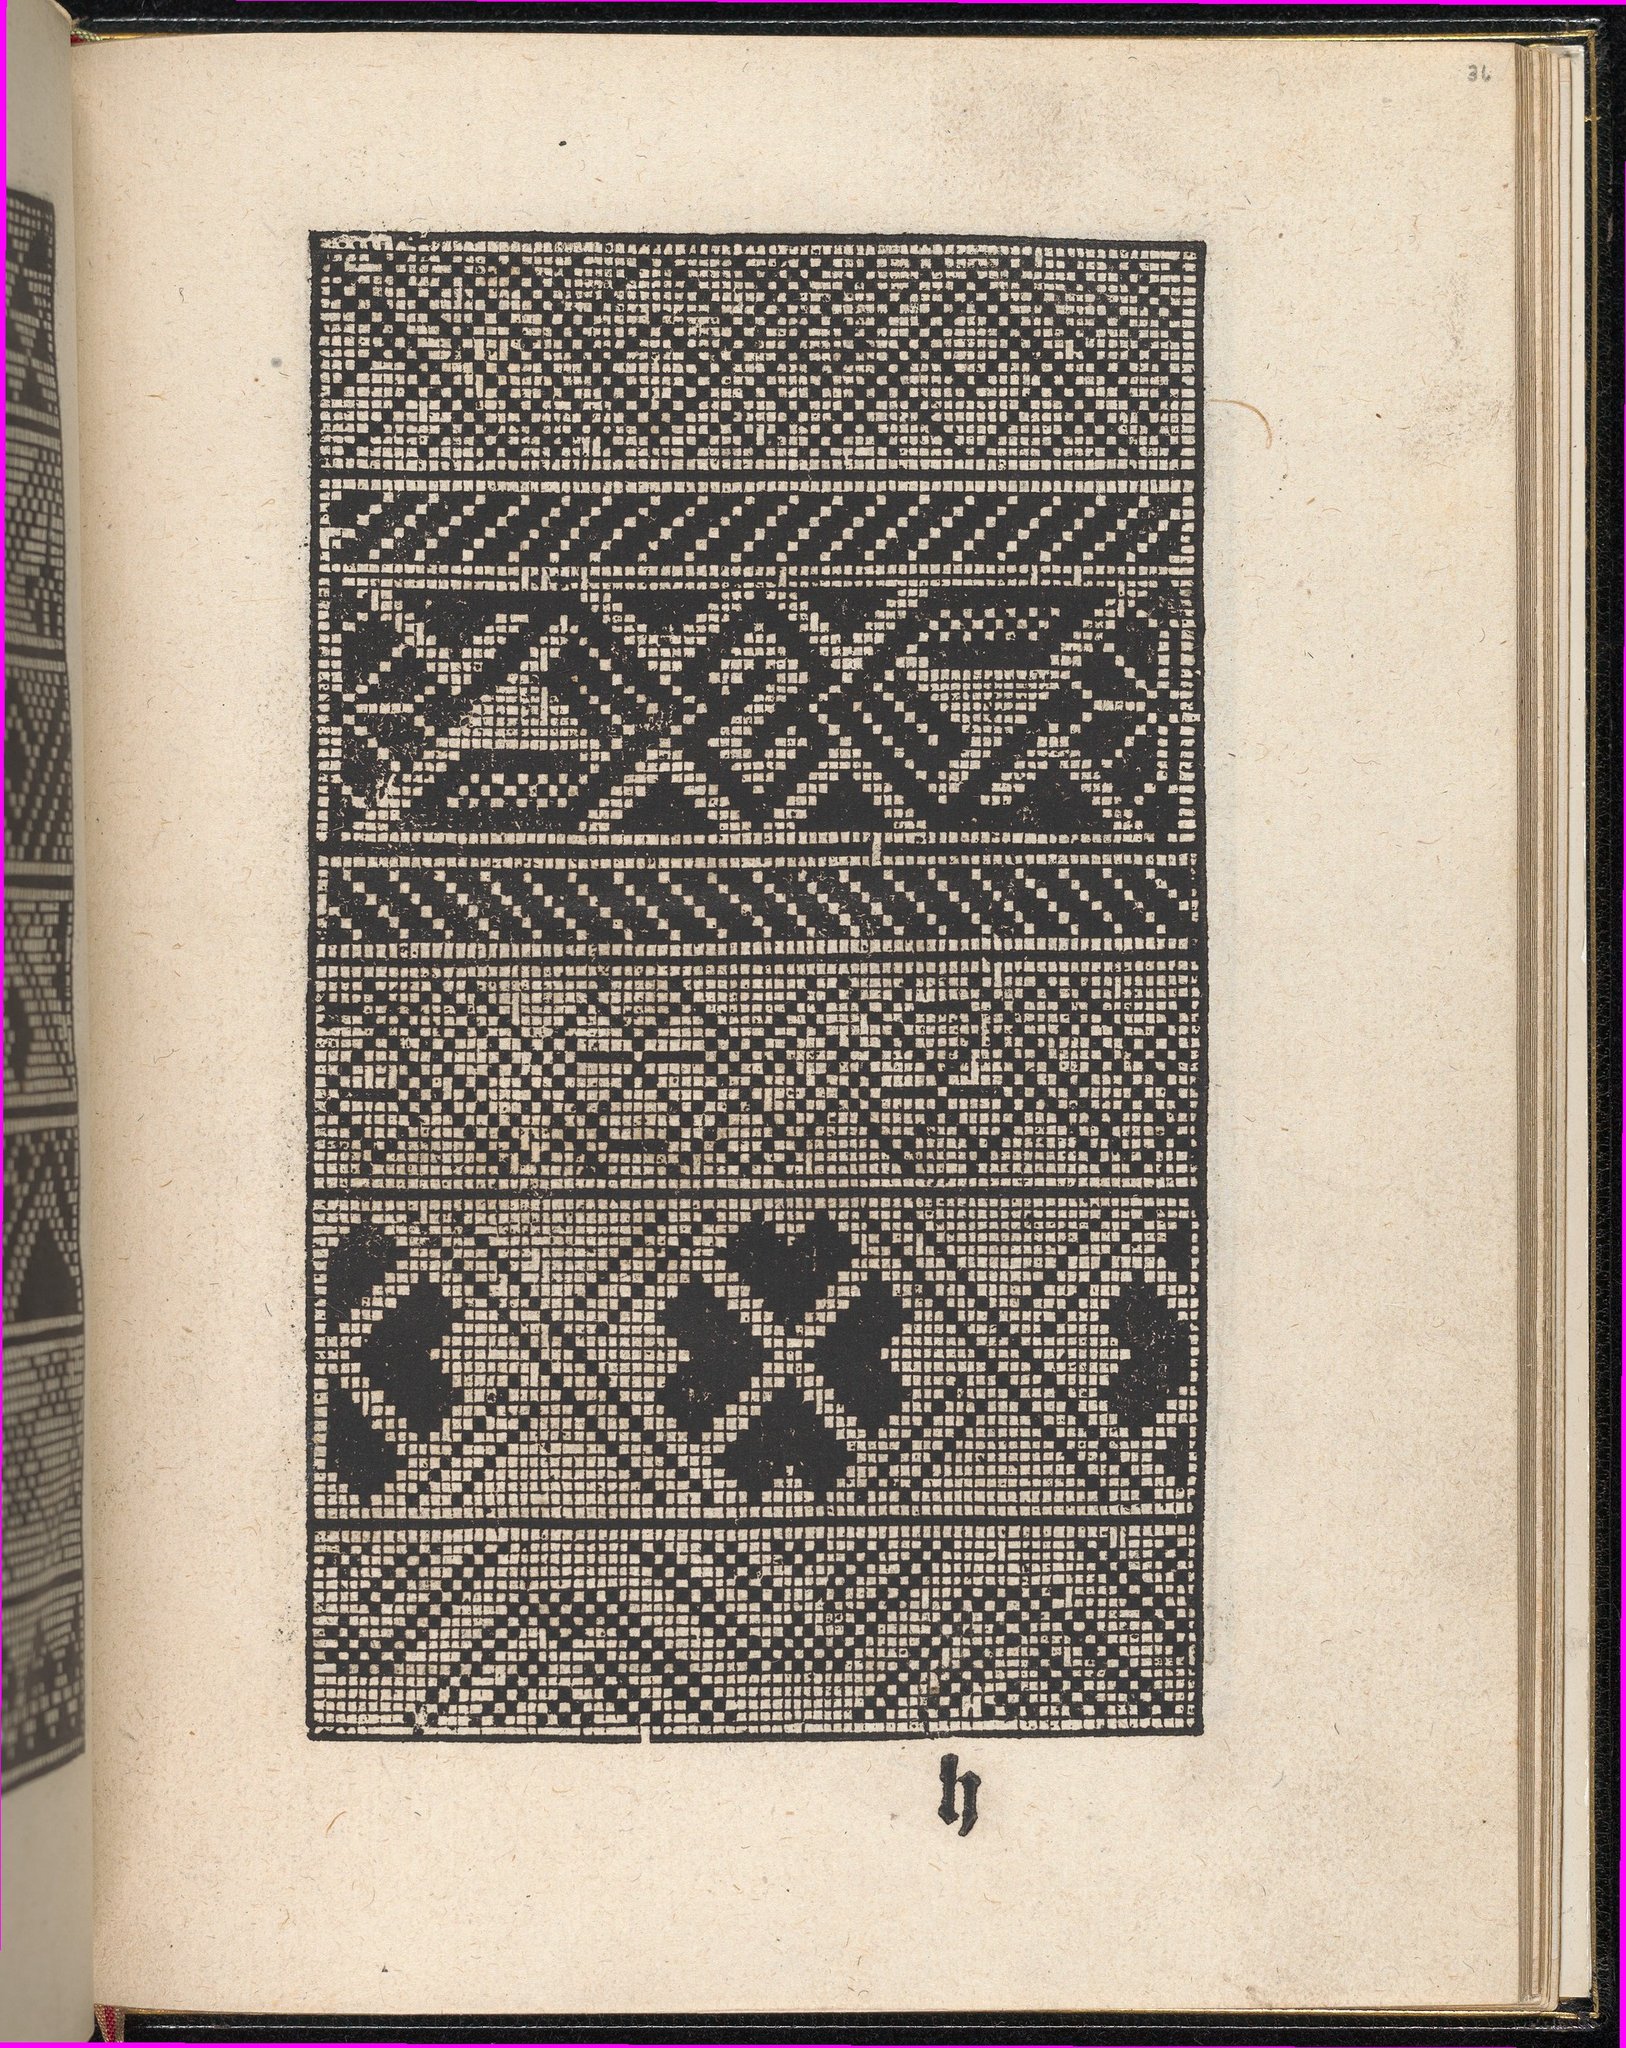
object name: book print ornament architecture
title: Page from Ein new kunstlich Modelbuch...(Page 36r)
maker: peter quentel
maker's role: publisher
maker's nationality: german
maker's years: 1500-1550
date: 1544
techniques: woodcut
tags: ornament